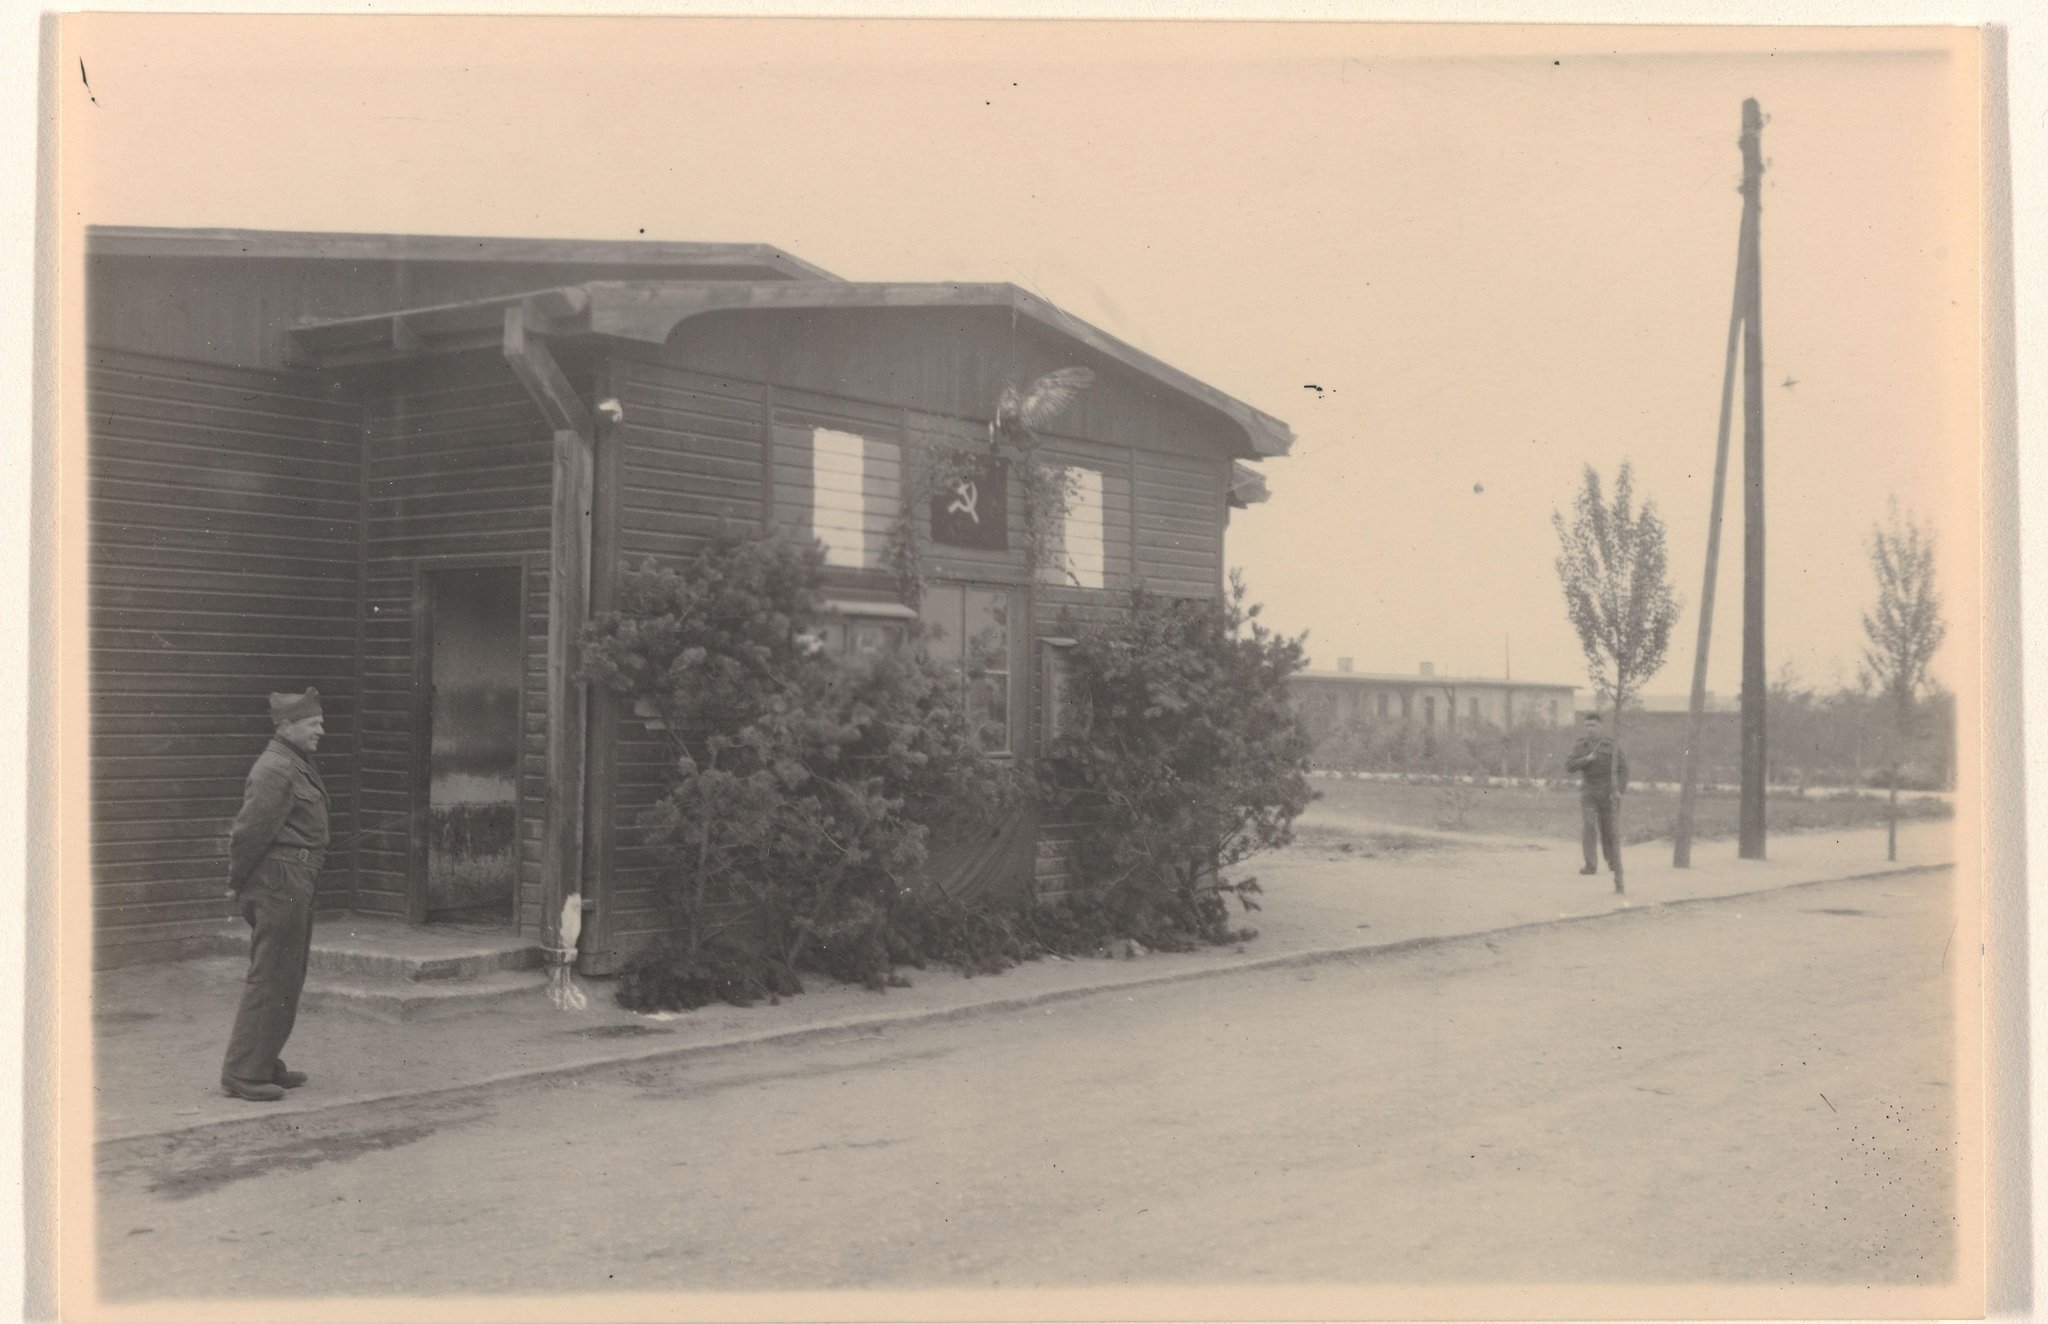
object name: photograph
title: Barak met Russische vlag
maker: dick w.b. van maarseveen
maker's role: fotograaf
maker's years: 1905-1990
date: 1945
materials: photographic support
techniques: gelatin silver print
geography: muhlberg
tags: the hague, dick w.b. van maarseveen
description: De Russische vlag hangt aan een van de barakken in het kamp. Het Russische leger bevrijdde het kamp op 23 april 1945. Onderdeel van een groep foto's gemaakt door Dick van Maarseveen in het Duitse krijgsgevangenenkamp Stalag IV B in Mühlberg in de periode 1943-1945.